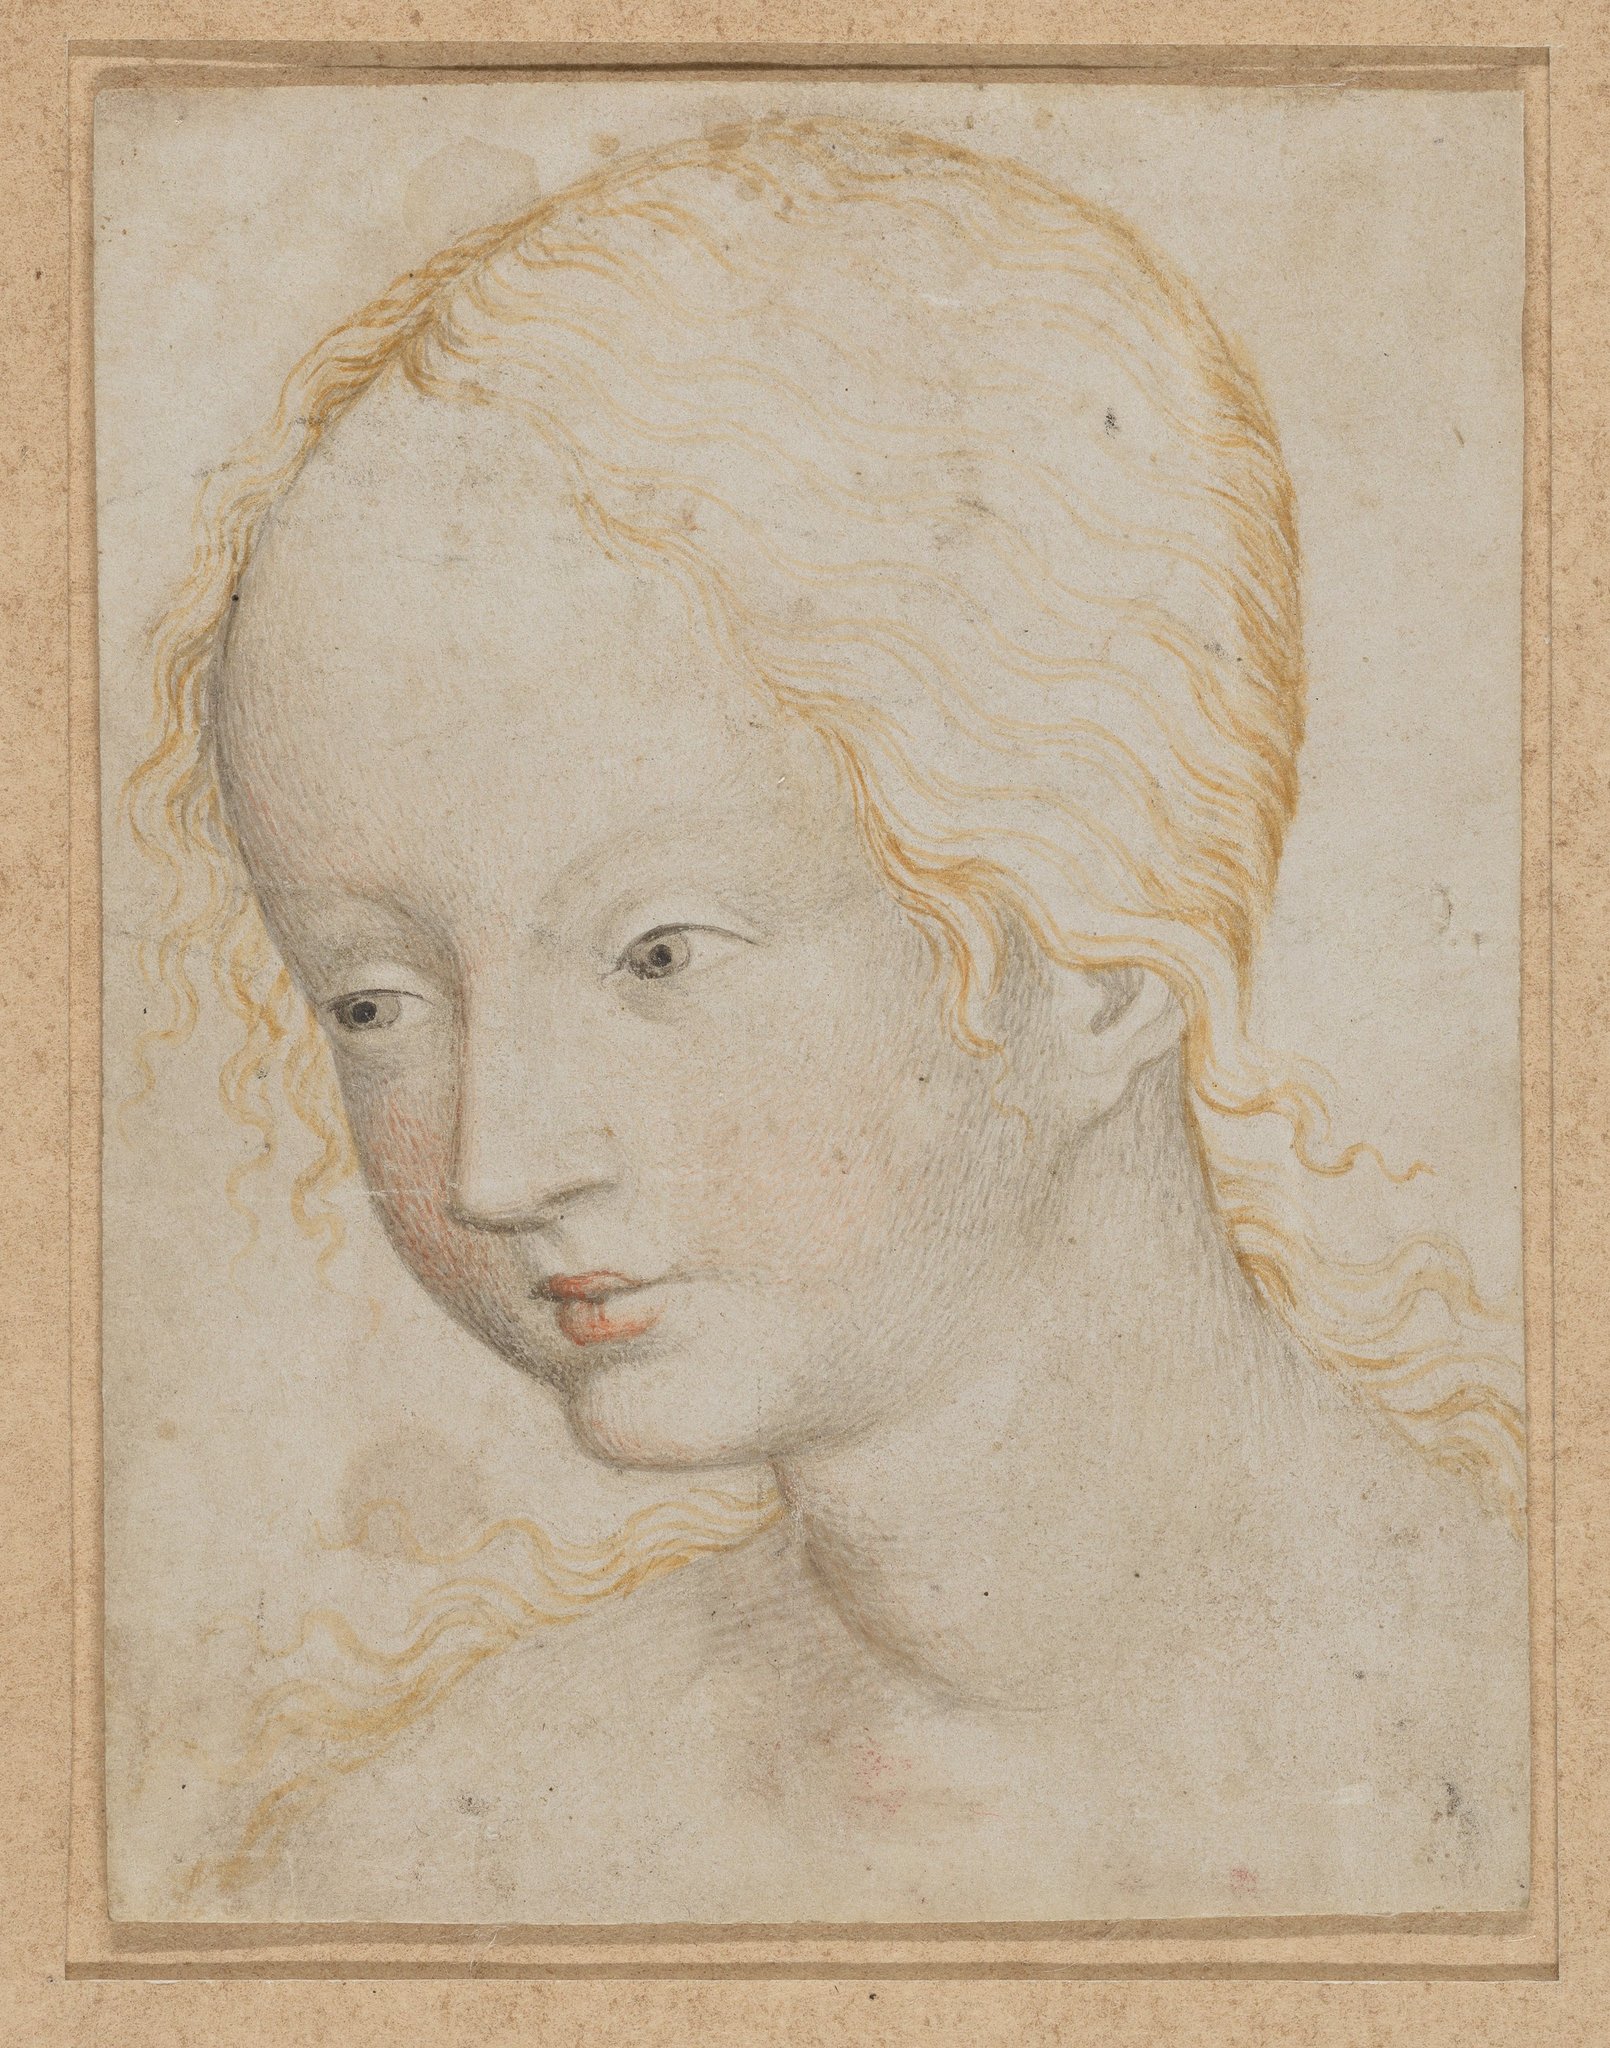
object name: drawing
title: Head of a Woman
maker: anonymous, bohemian, 15th century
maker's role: artist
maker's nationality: bohemian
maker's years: 1300-1400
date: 1405-1410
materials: parchment, watercolor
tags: women